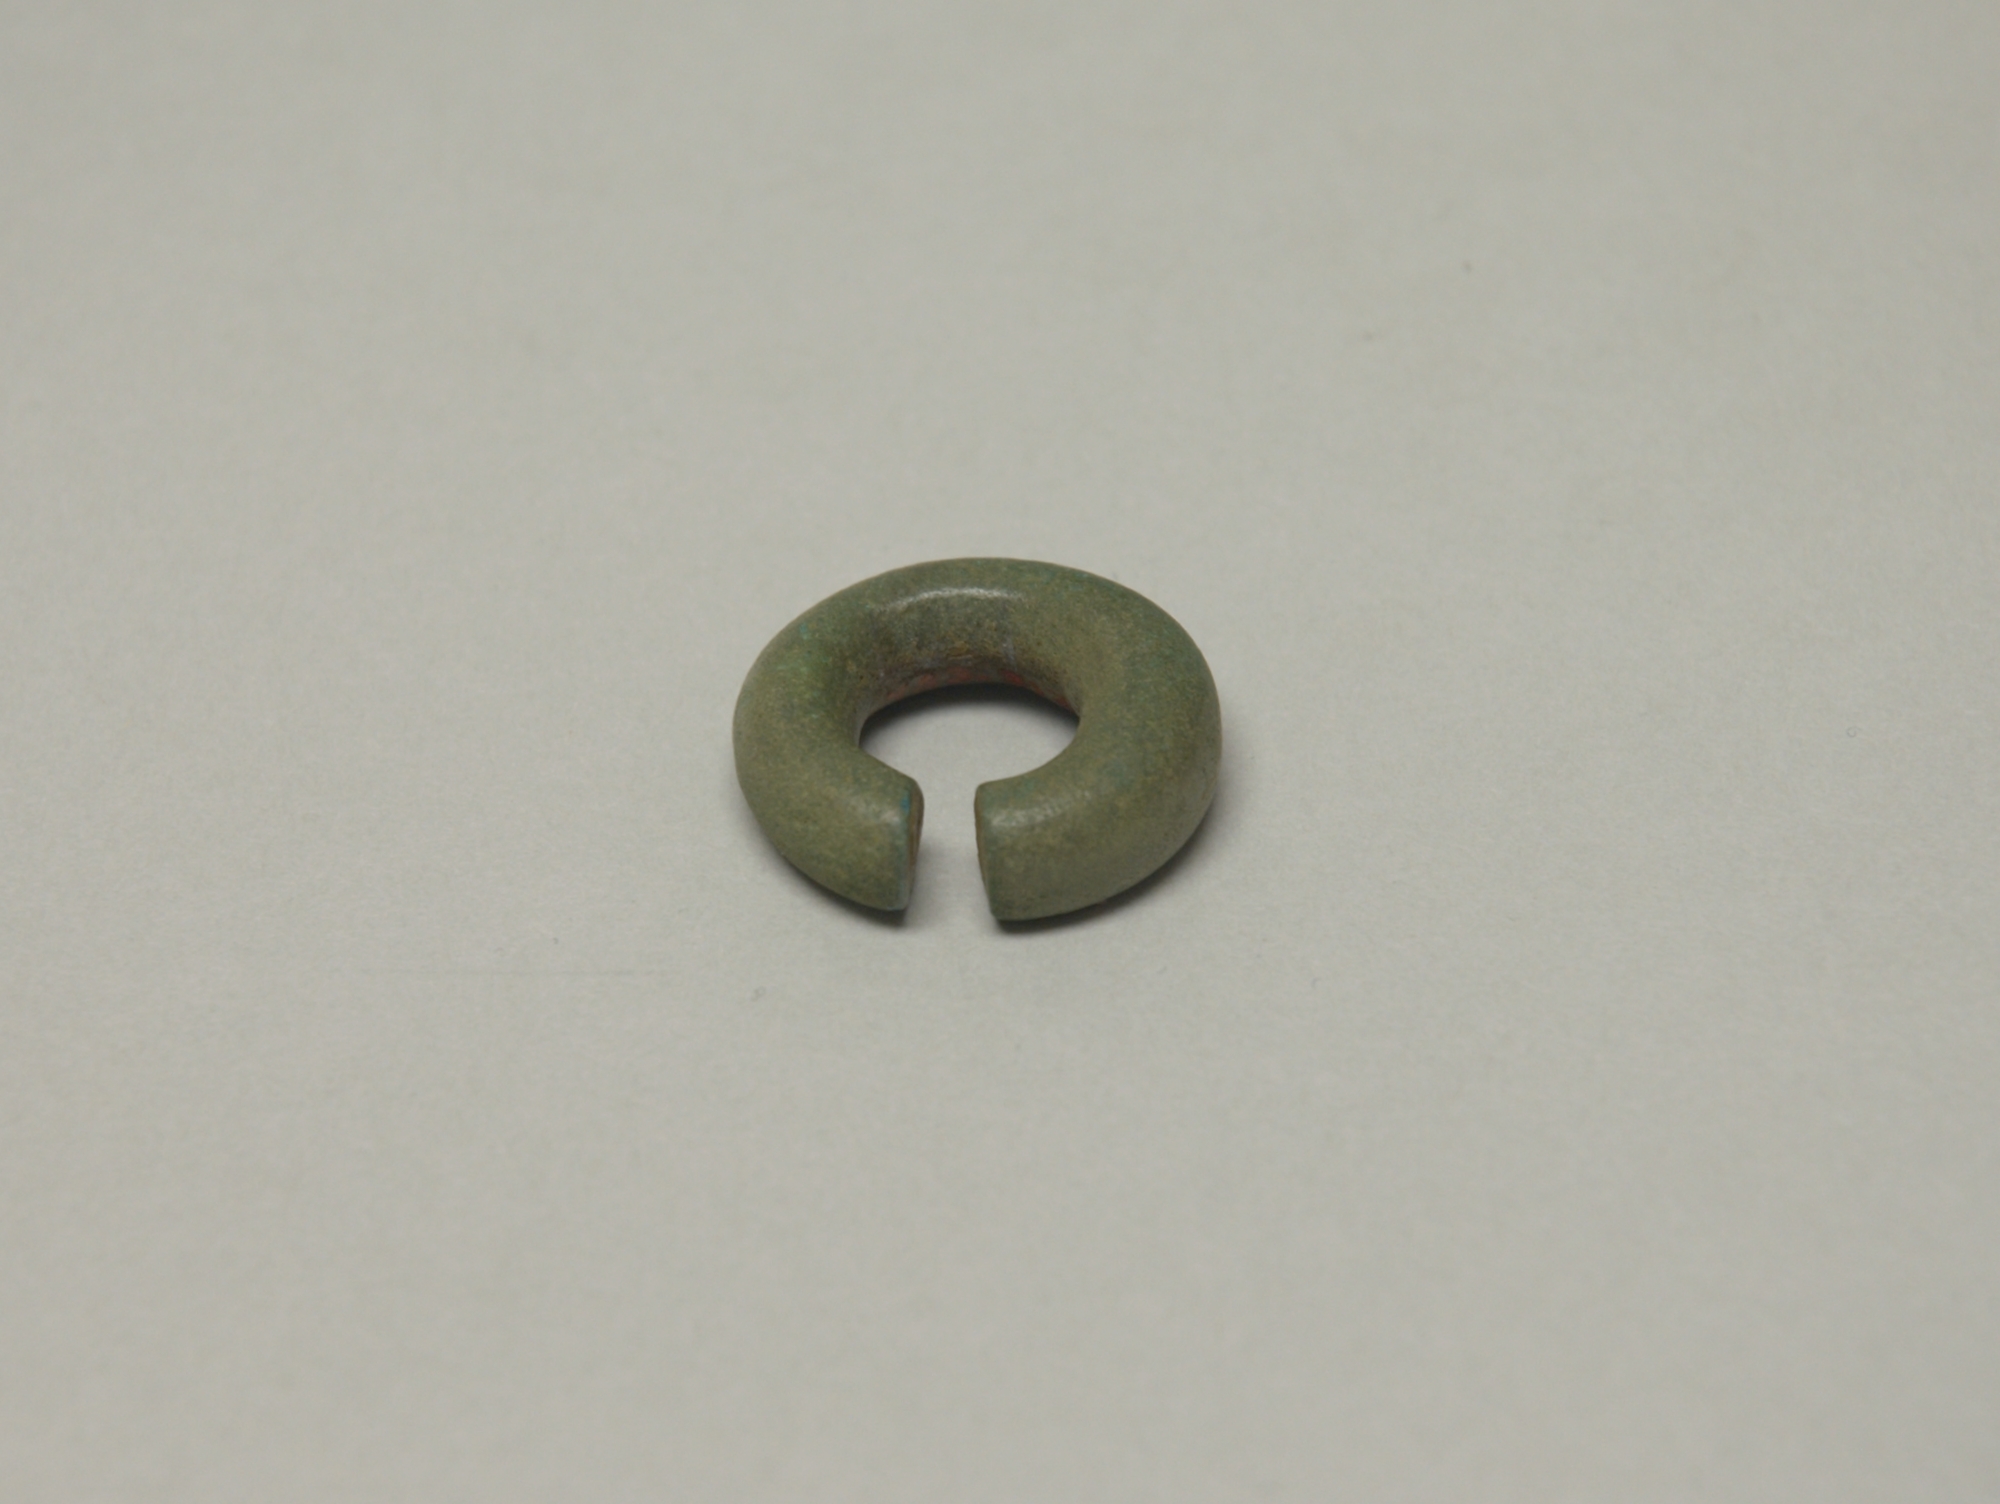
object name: earring with pendant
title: Ear Pendant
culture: thai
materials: glass